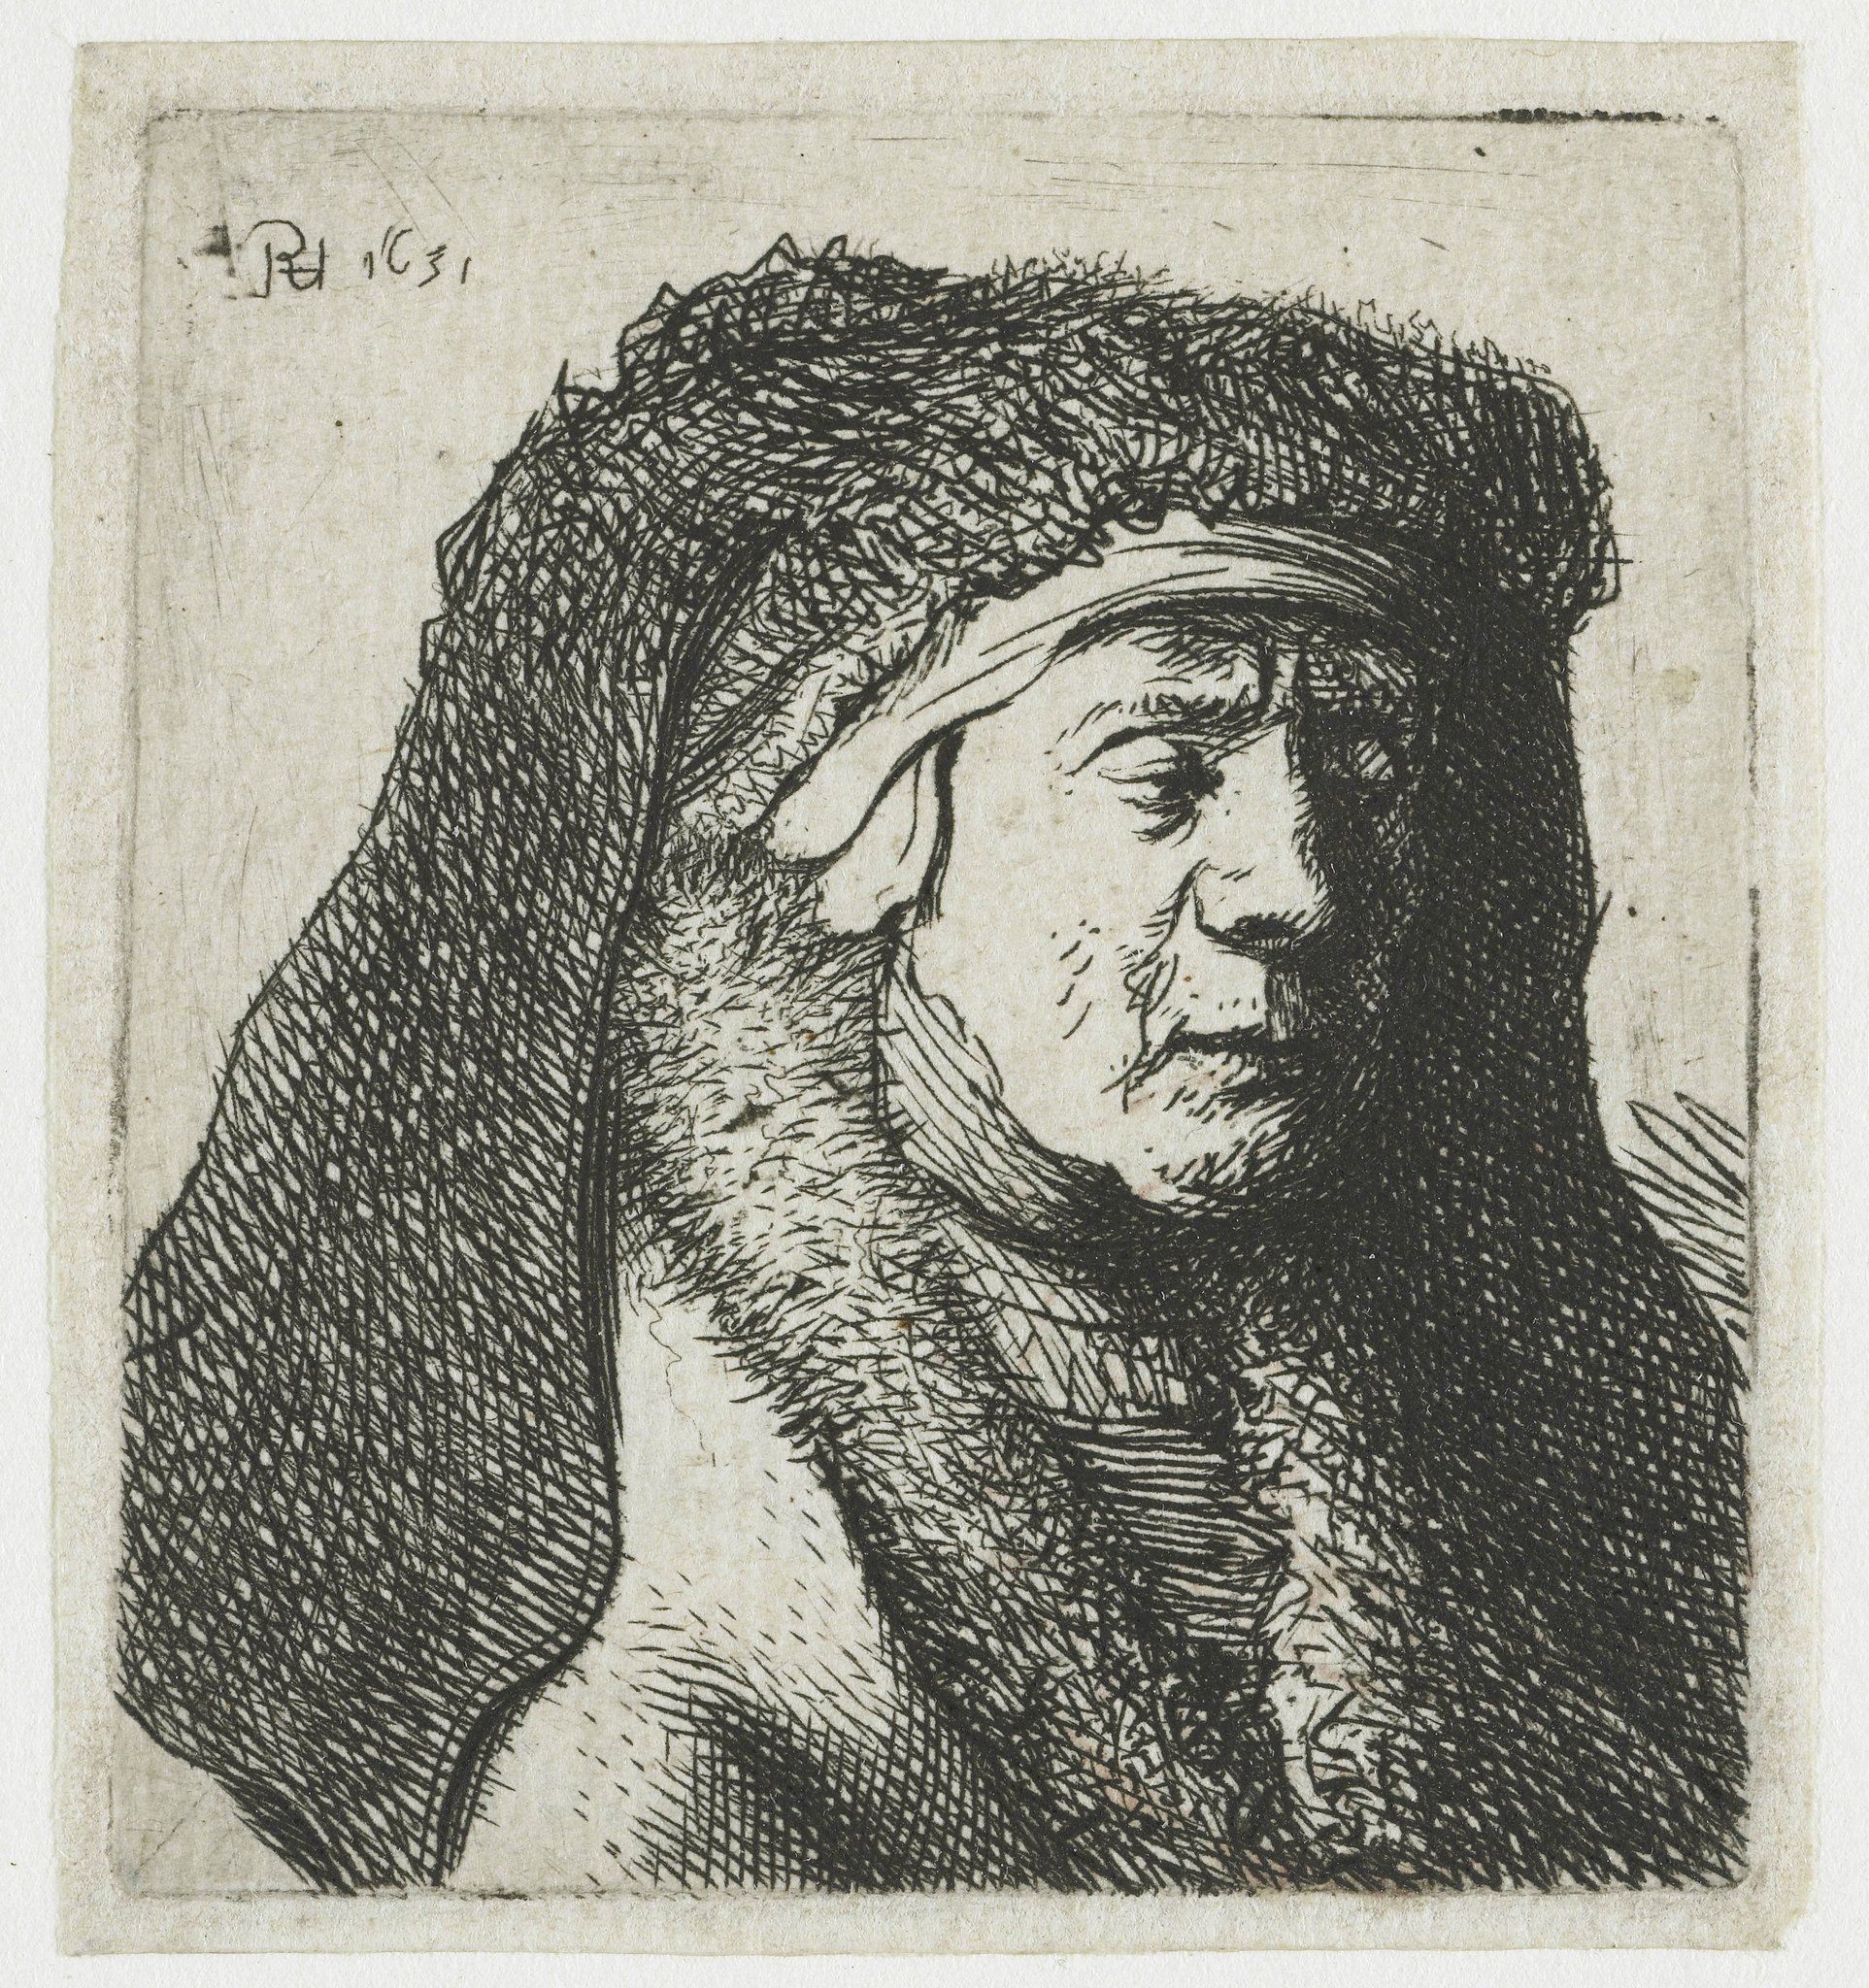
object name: print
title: Bust of an old woman in a furred cloak and heavy headdress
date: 1631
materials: paper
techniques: etching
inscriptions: collector's mark: Lugt 240, monogram and date: ‘RHL 1631’